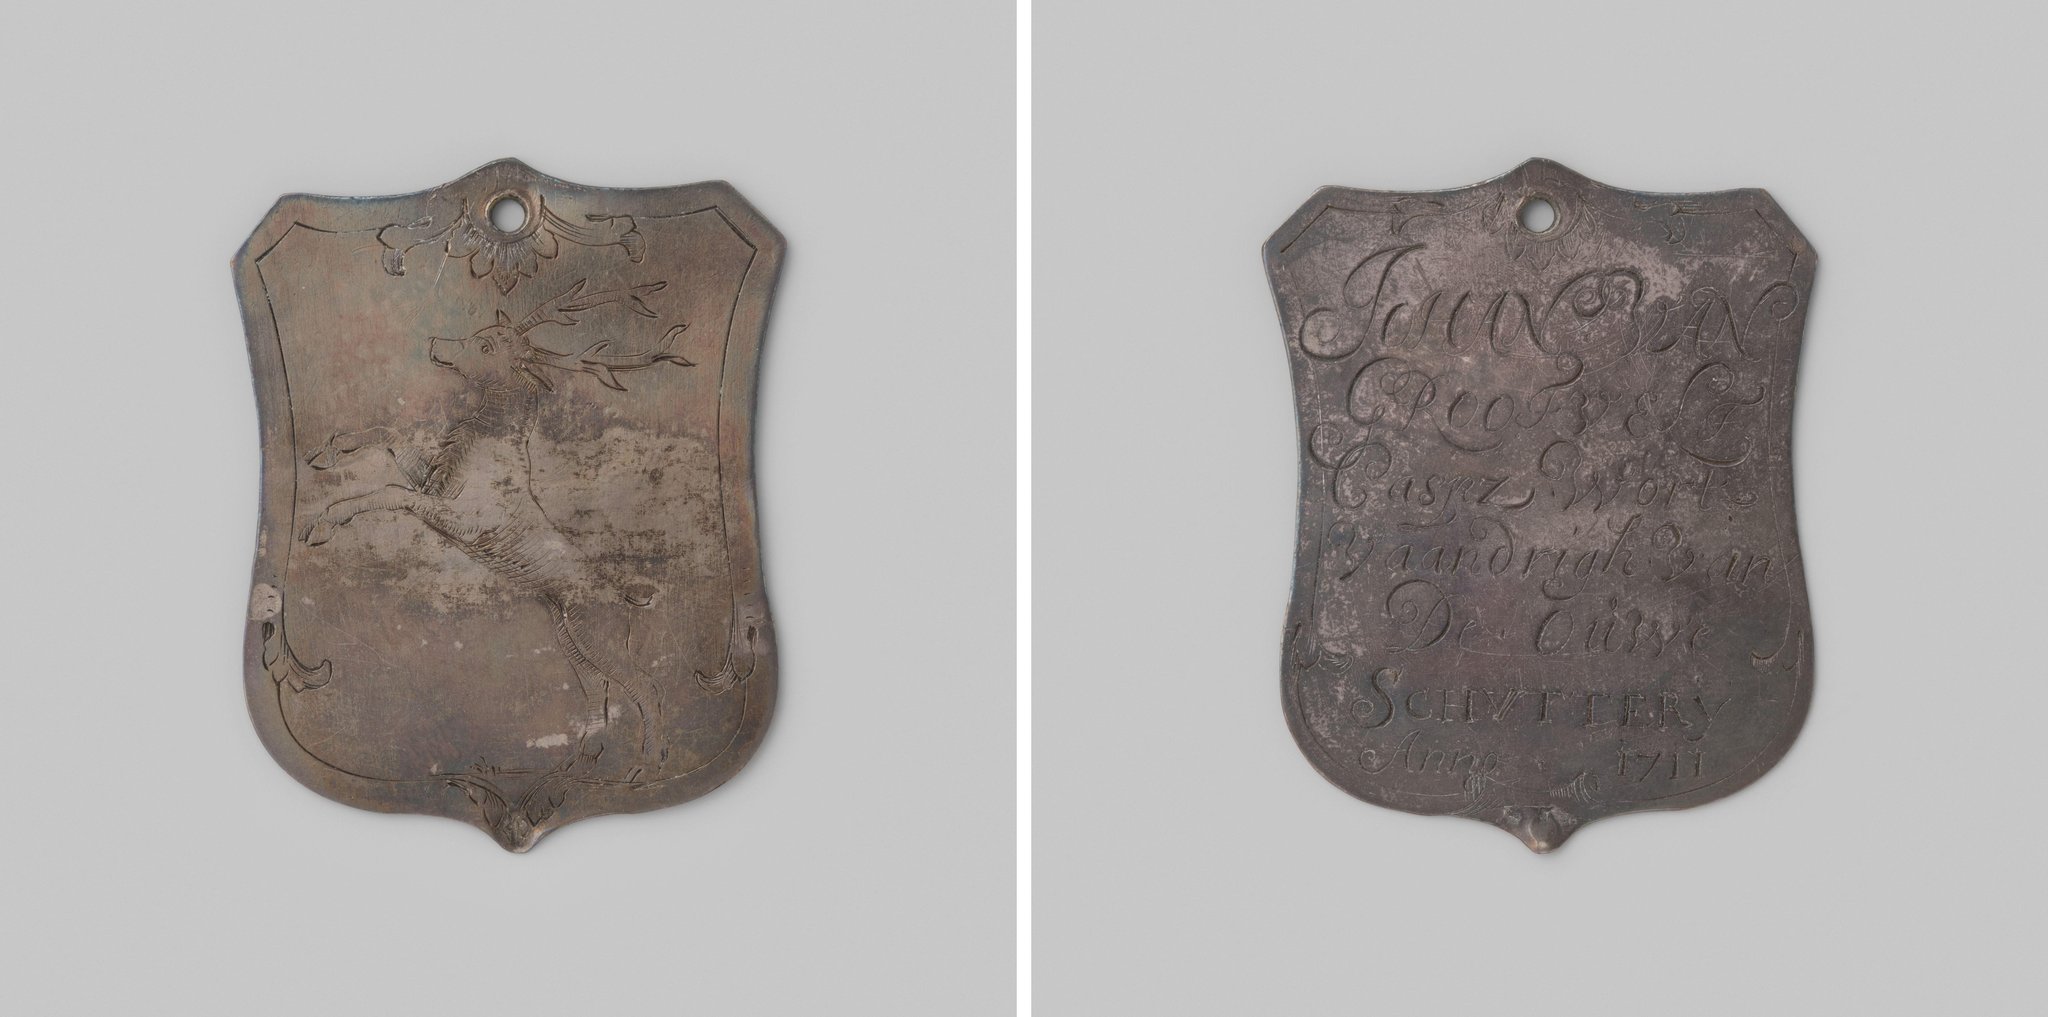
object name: medal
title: Penning in de vorm van een schild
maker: Anonymous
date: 1711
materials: metal